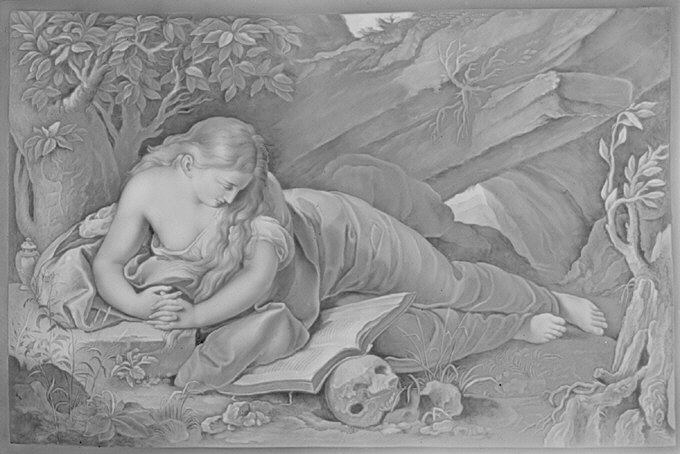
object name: lithophane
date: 1834-1866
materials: porcelain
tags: books,women,reading